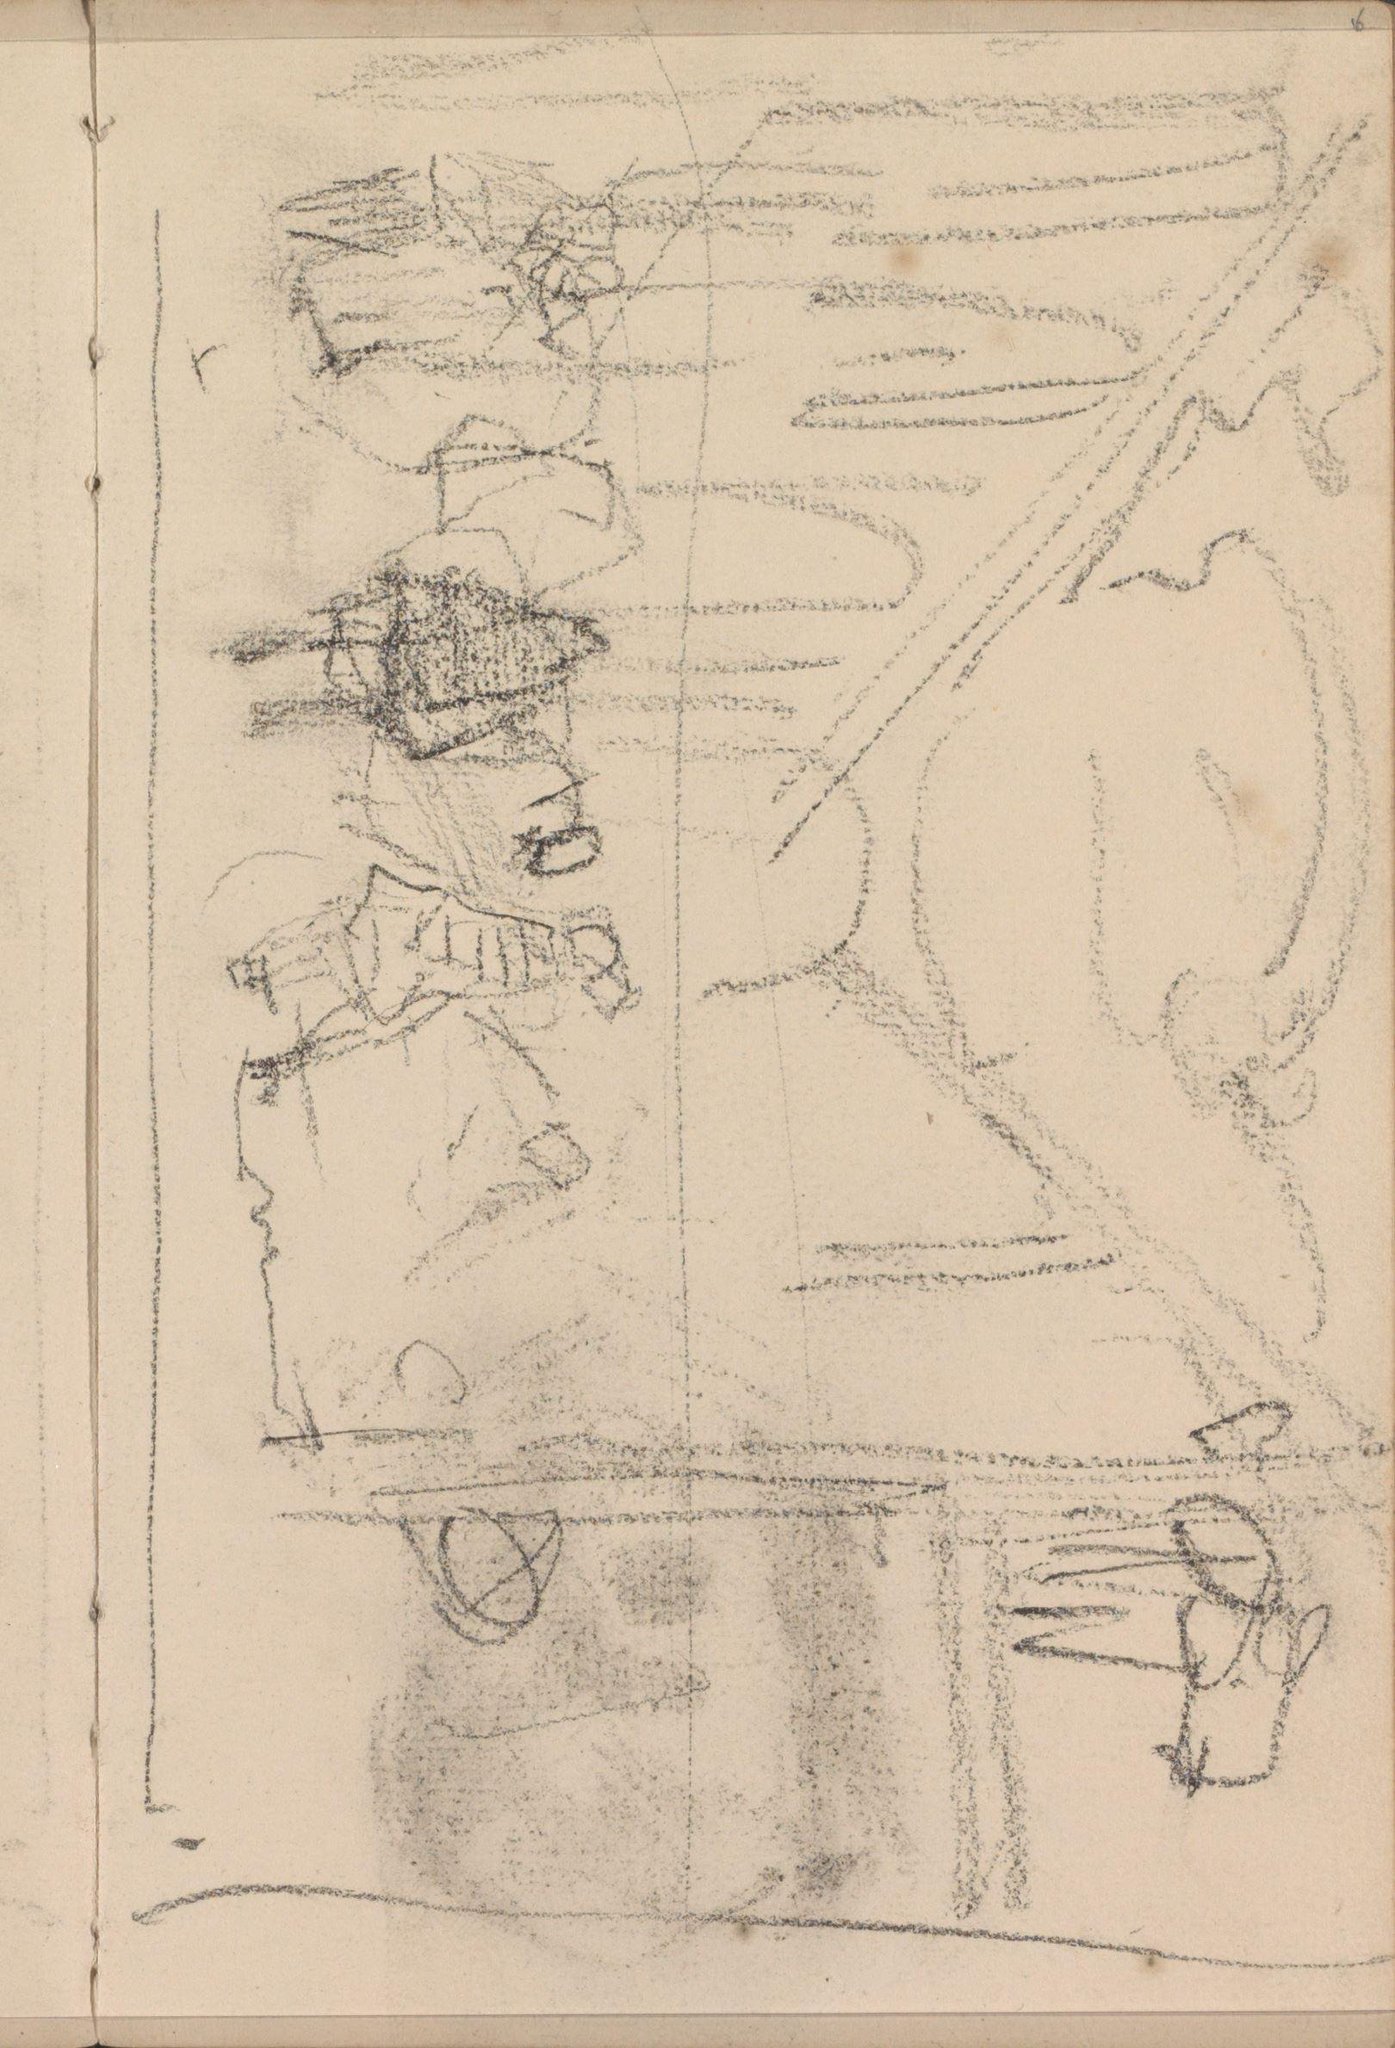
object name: sketchbook leaf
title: Figuren tussen bogen, mogelijk van een arcade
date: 1881-1883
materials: chalk, paper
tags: adult woman, adult man, arcade ~ architecture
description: Pagina 16 uit een schetsboek met 19 bladen.